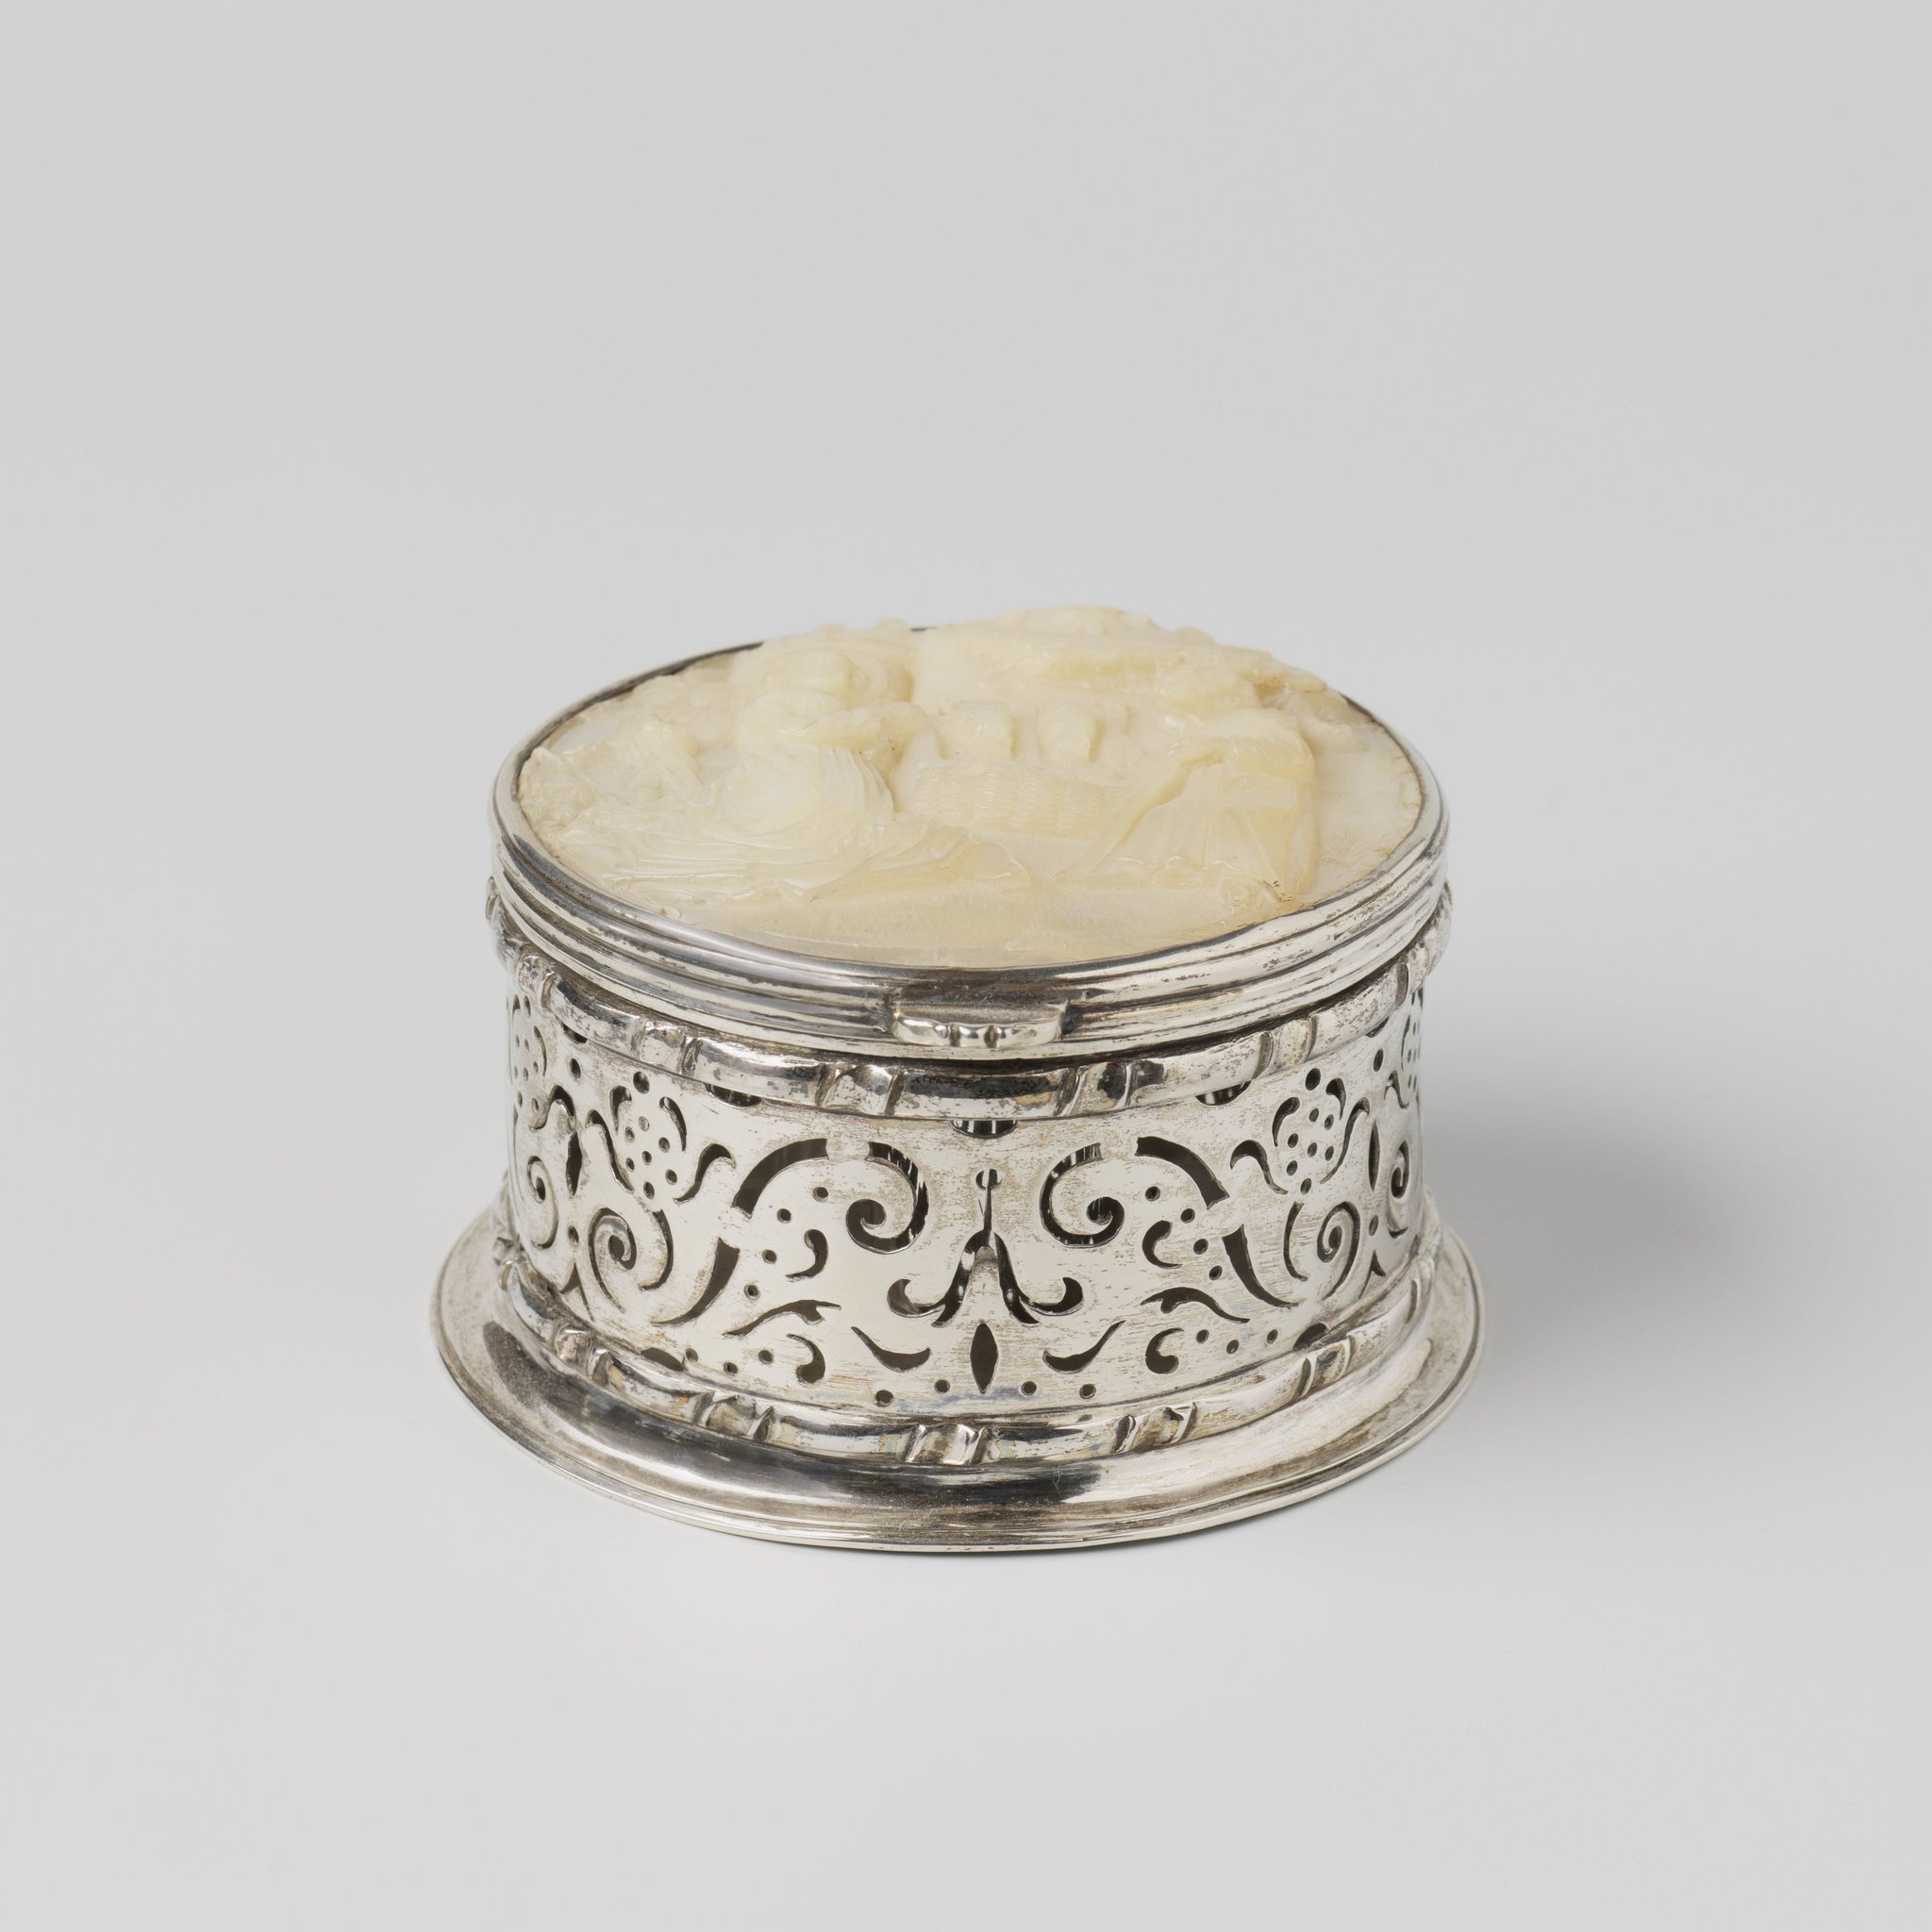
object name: box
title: Doos, inktkoker, met gezaagd rankenornament en deksel van parelmoer waarop een voorstelling van de Geboorte van Christus. In de doos drie bussen met deksel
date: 1773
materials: mother of pearl, silver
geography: zutphen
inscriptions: mark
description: The Nativity. Mother-of-pearl. Middle Rhine, c. 1450 - 1475. Used as a lid on a silver ink pot. Zutphen, 1773, Hendrik Jurriën Wolters.